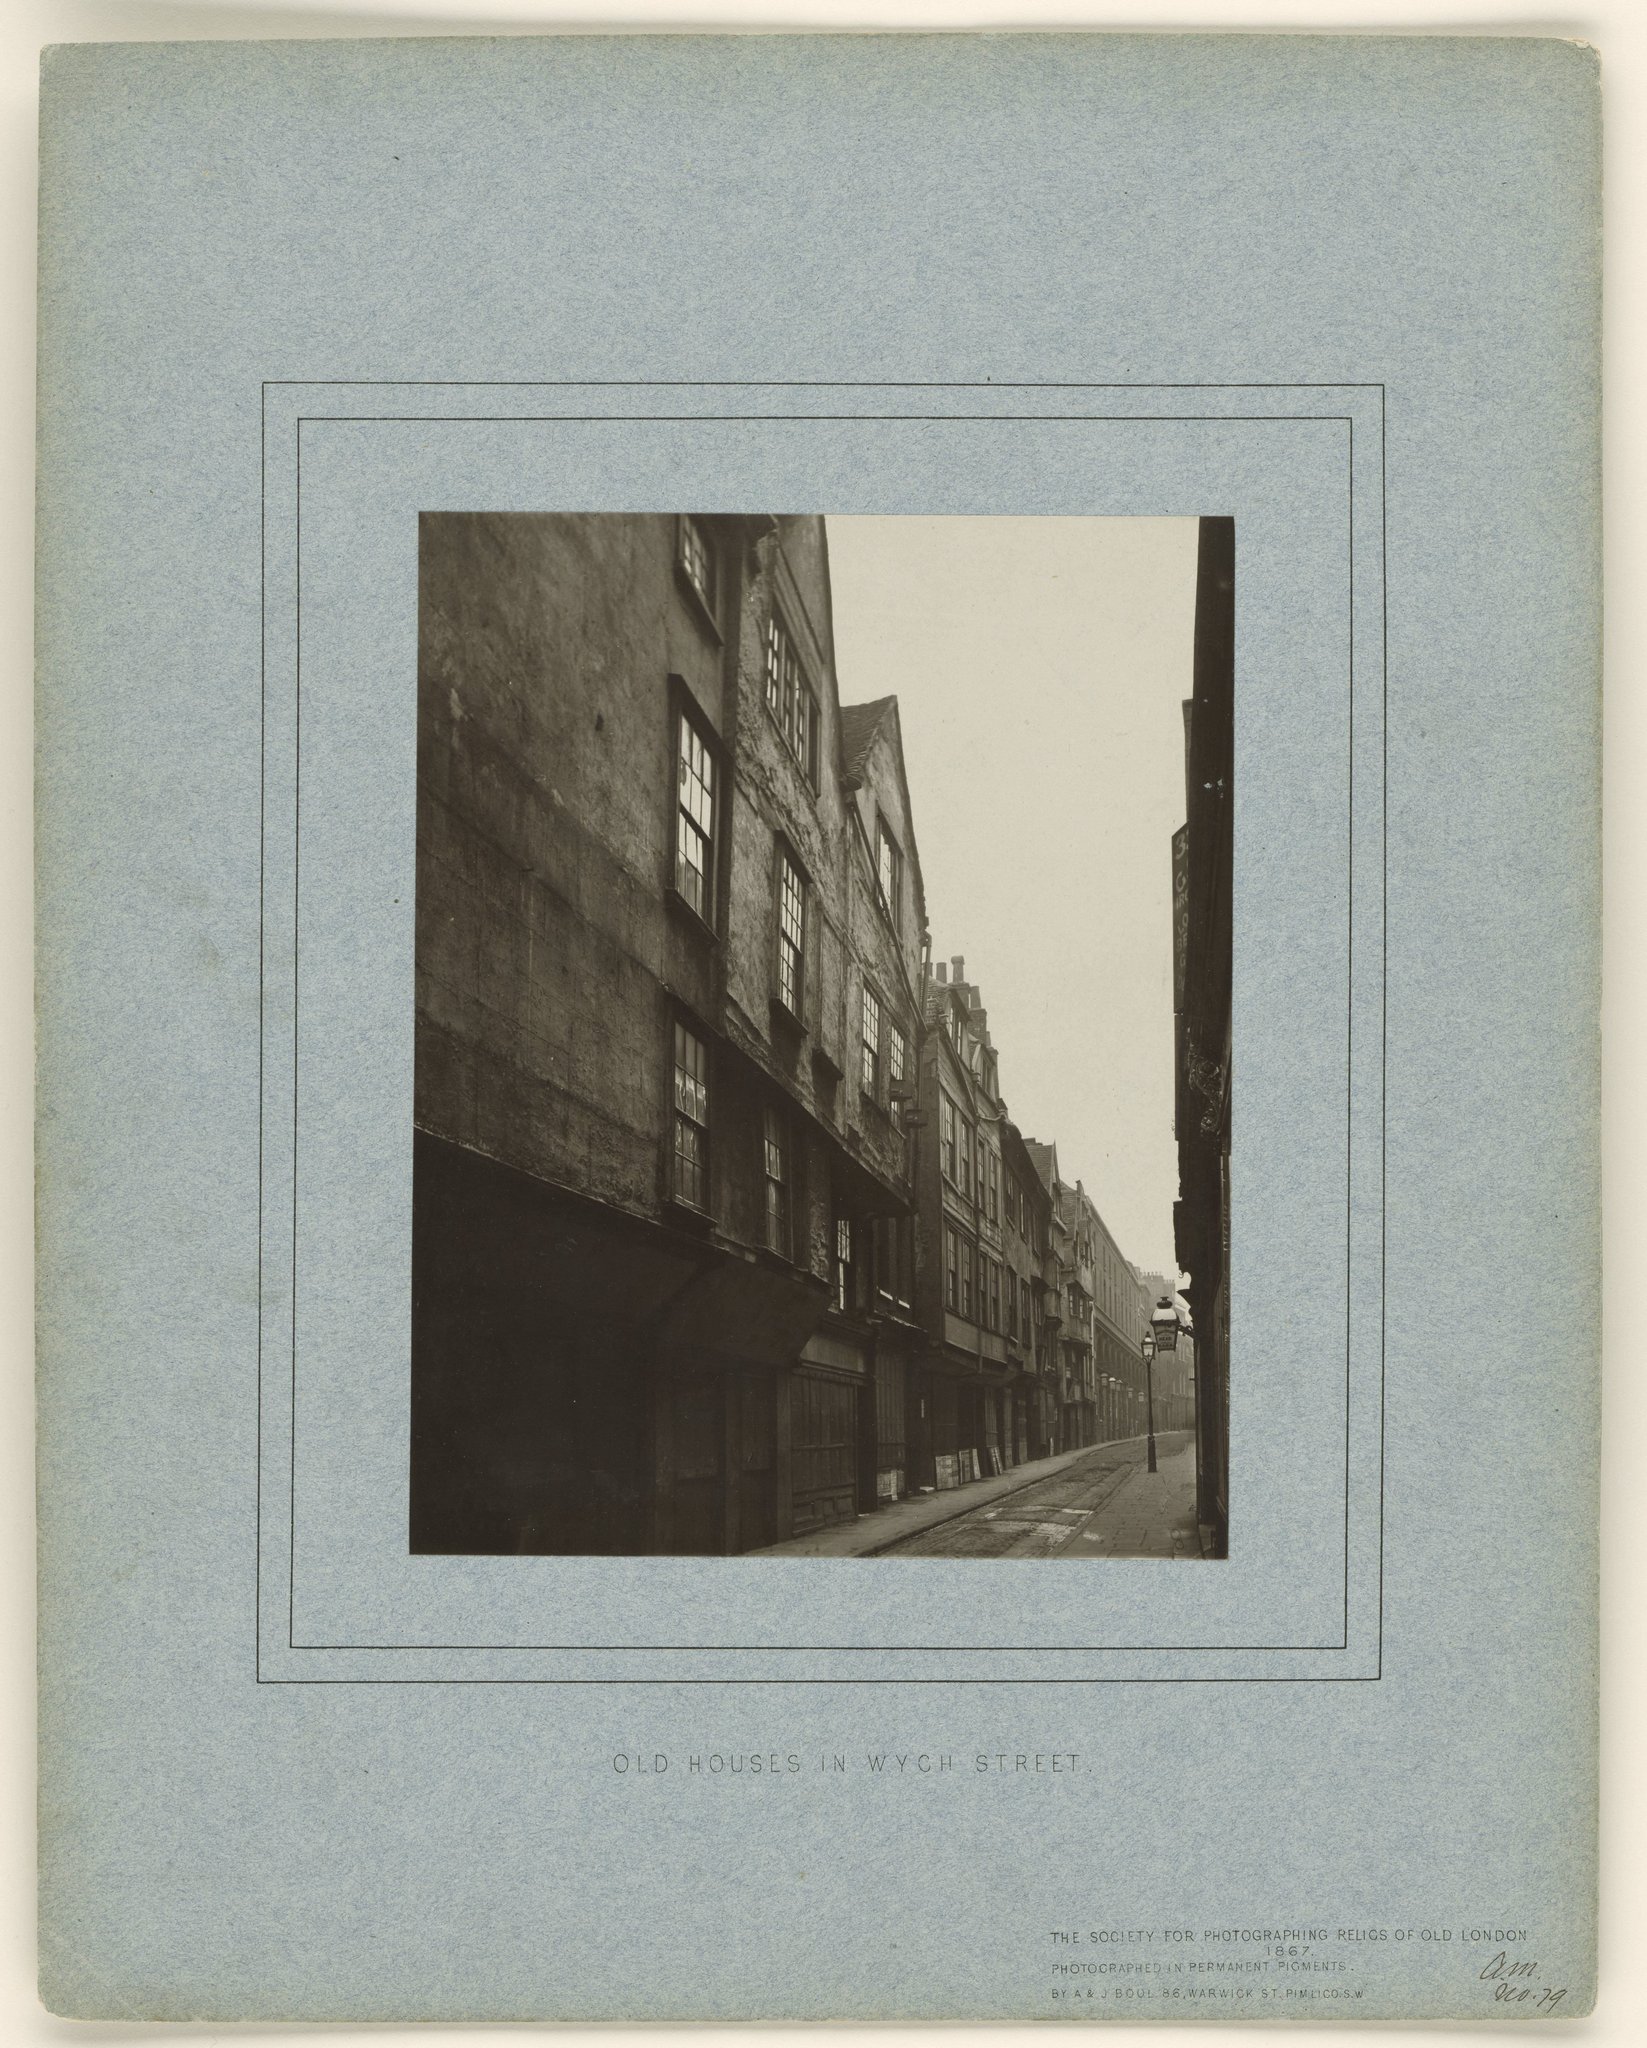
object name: photograph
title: Old houses in Wych Street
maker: henry dixon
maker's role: fotograaf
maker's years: 1820-1893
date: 1875-1886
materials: cardboard, photographic support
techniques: carbon print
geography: london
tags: street, london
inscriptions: inscription: ‘1867/ PHOTOGRAPHED IN PERMANENT PIGMENTS./ BY A & J BOOL 86, WARWICK ST. PIMLICO. S.W.’, number: ‘Am/ no. 79’